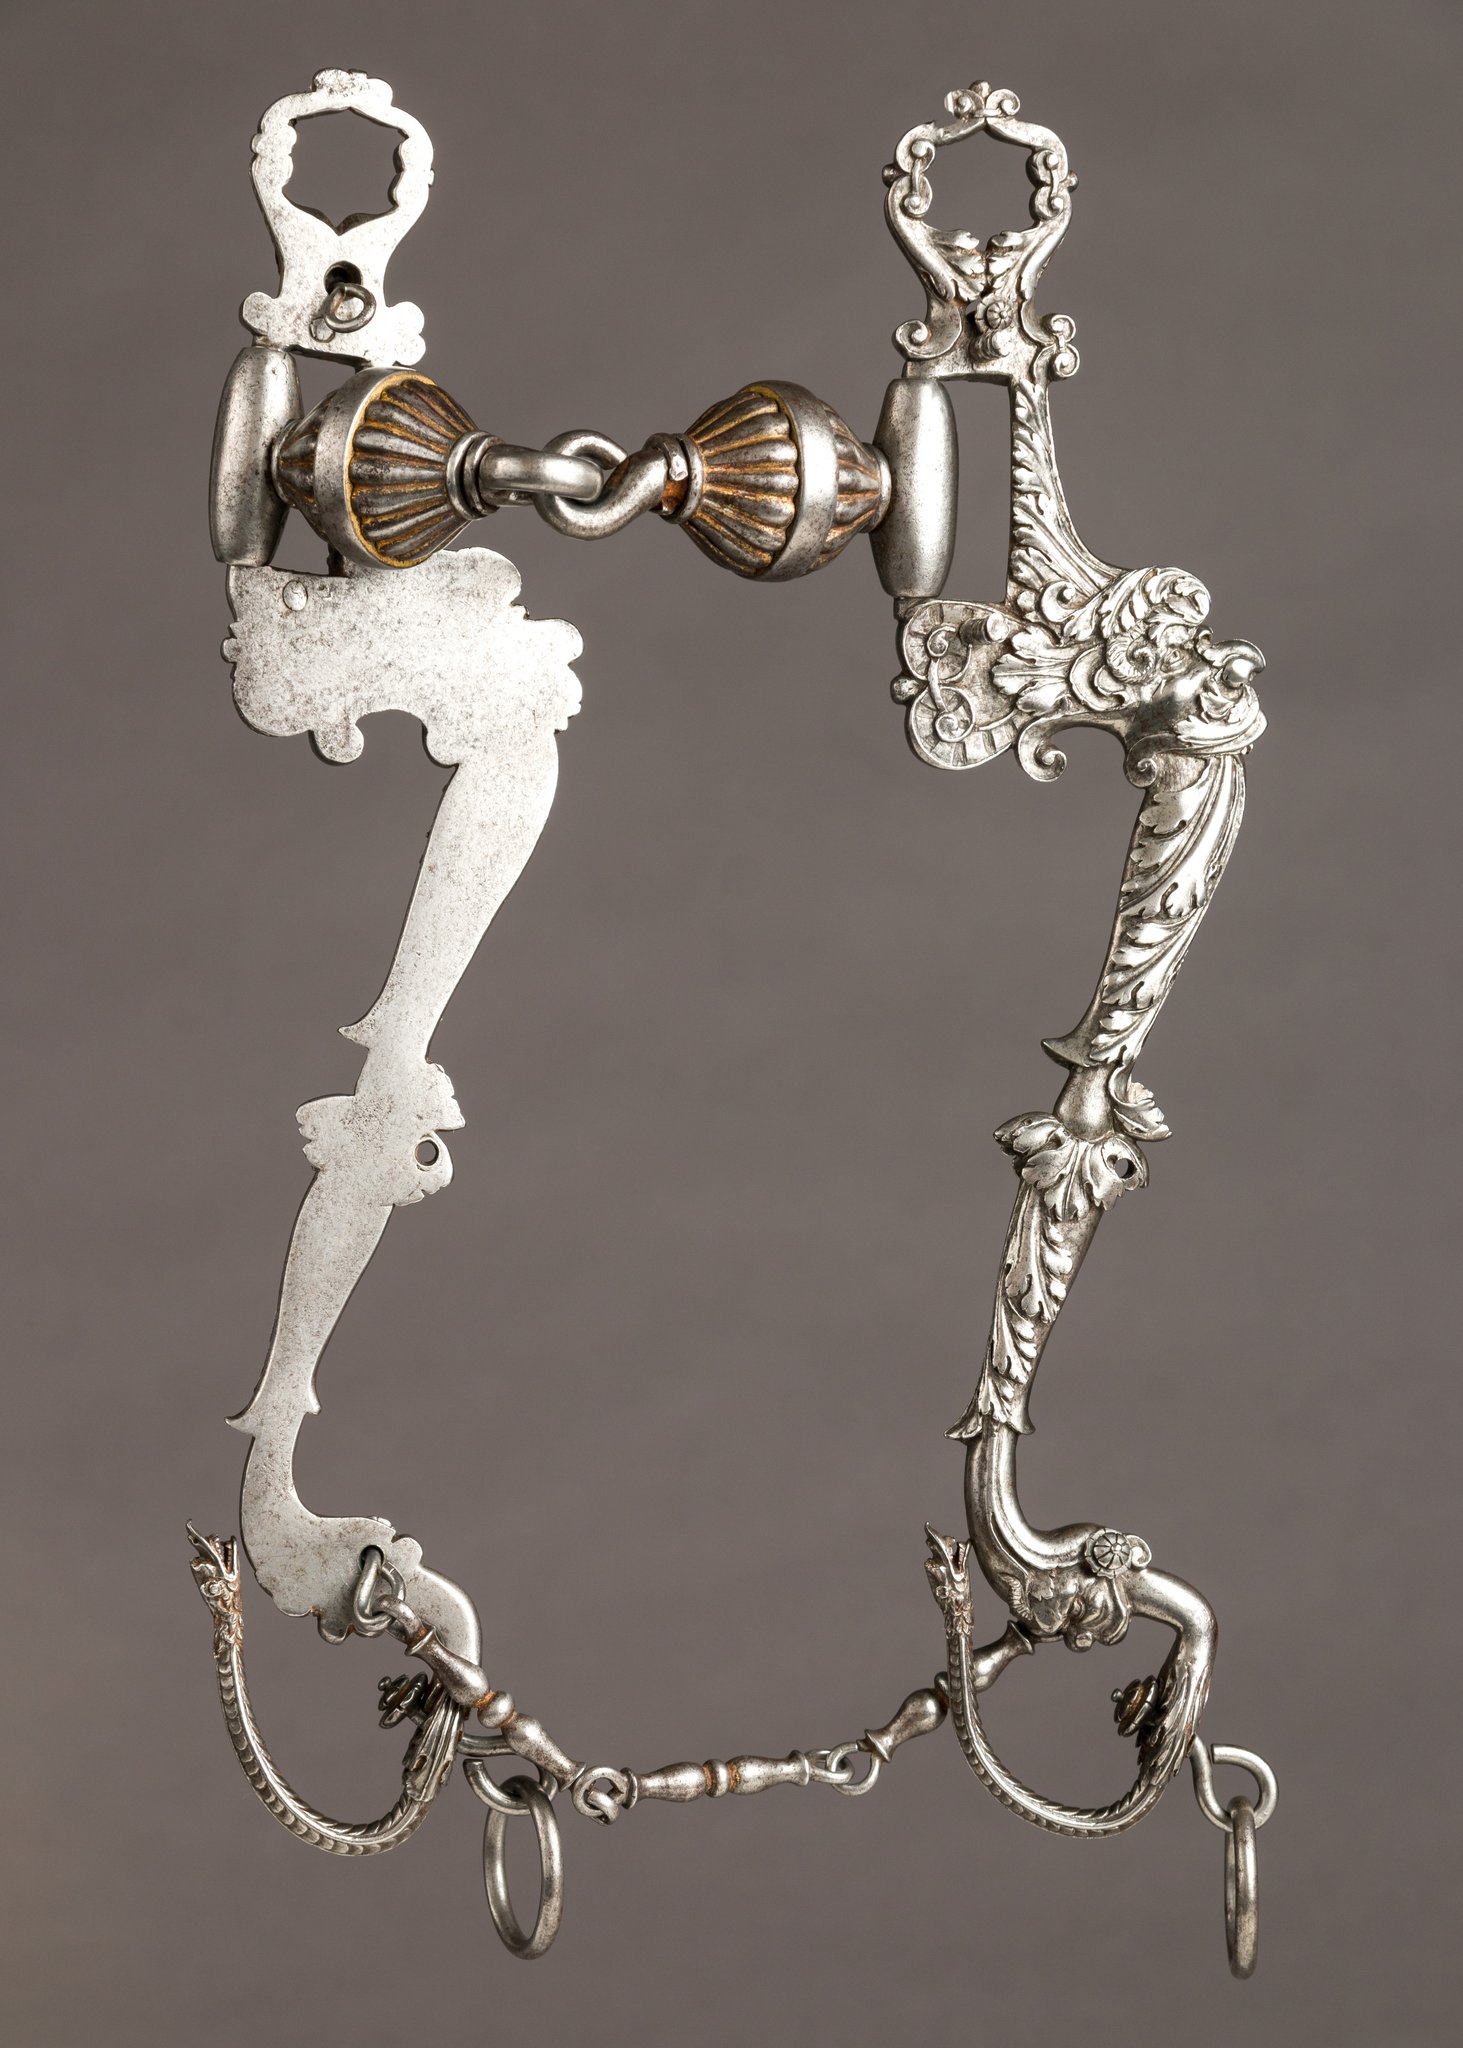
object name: bit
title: Curb Bit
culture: north italian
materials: gold, metal alloy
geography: italy